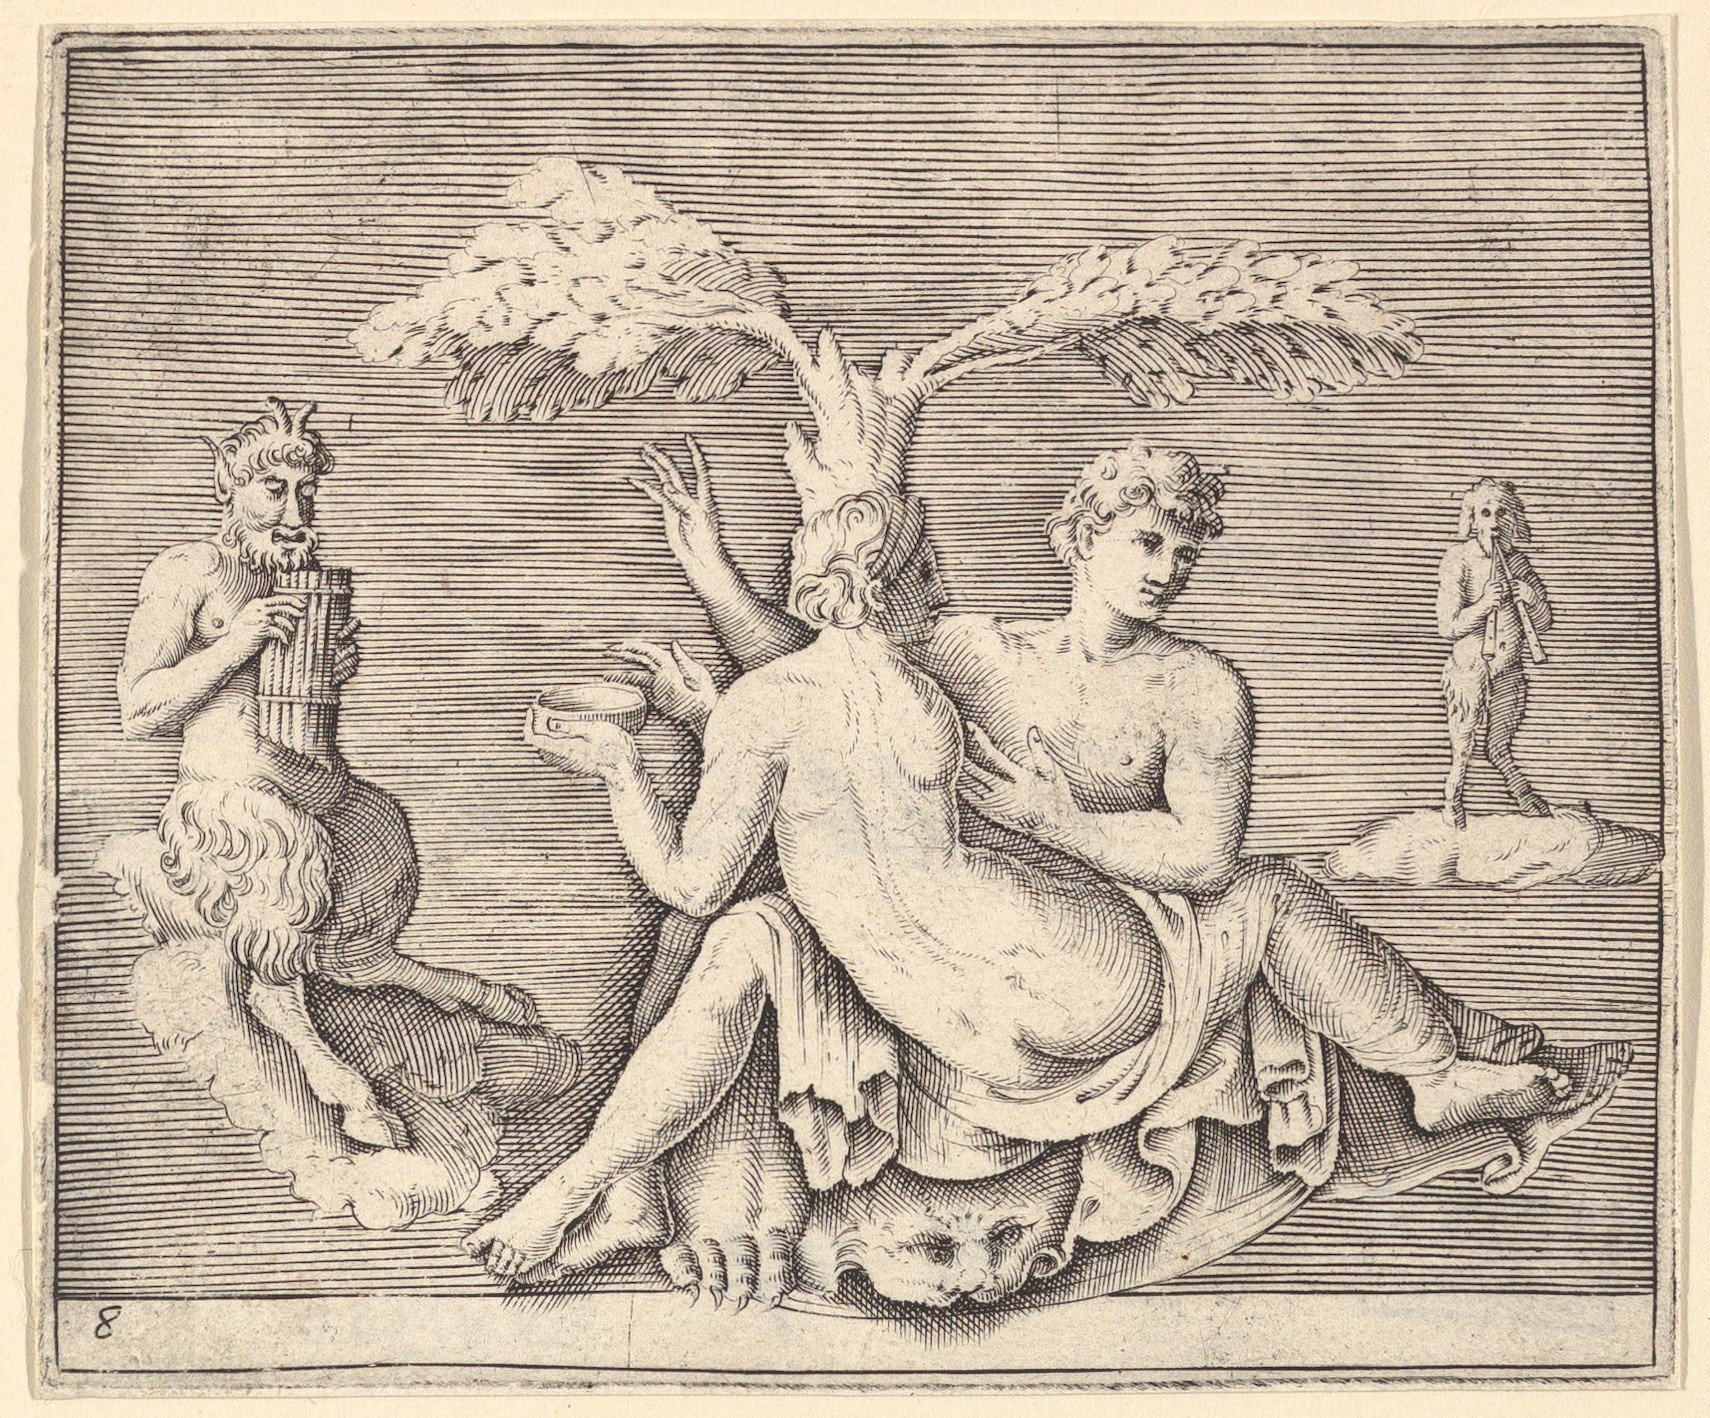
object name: print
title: Two Lovers with Pan, from "Ex Antiquis Cameorum et Gemmae Delineata/ Liber Secundus/et ab Enea Vico Parmen Incis"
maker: anonymous, italian, 16th century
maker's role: artist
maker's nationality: italian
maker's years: 1500-1600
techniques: engraving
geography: rome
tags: male nudes,lovers,female nudes